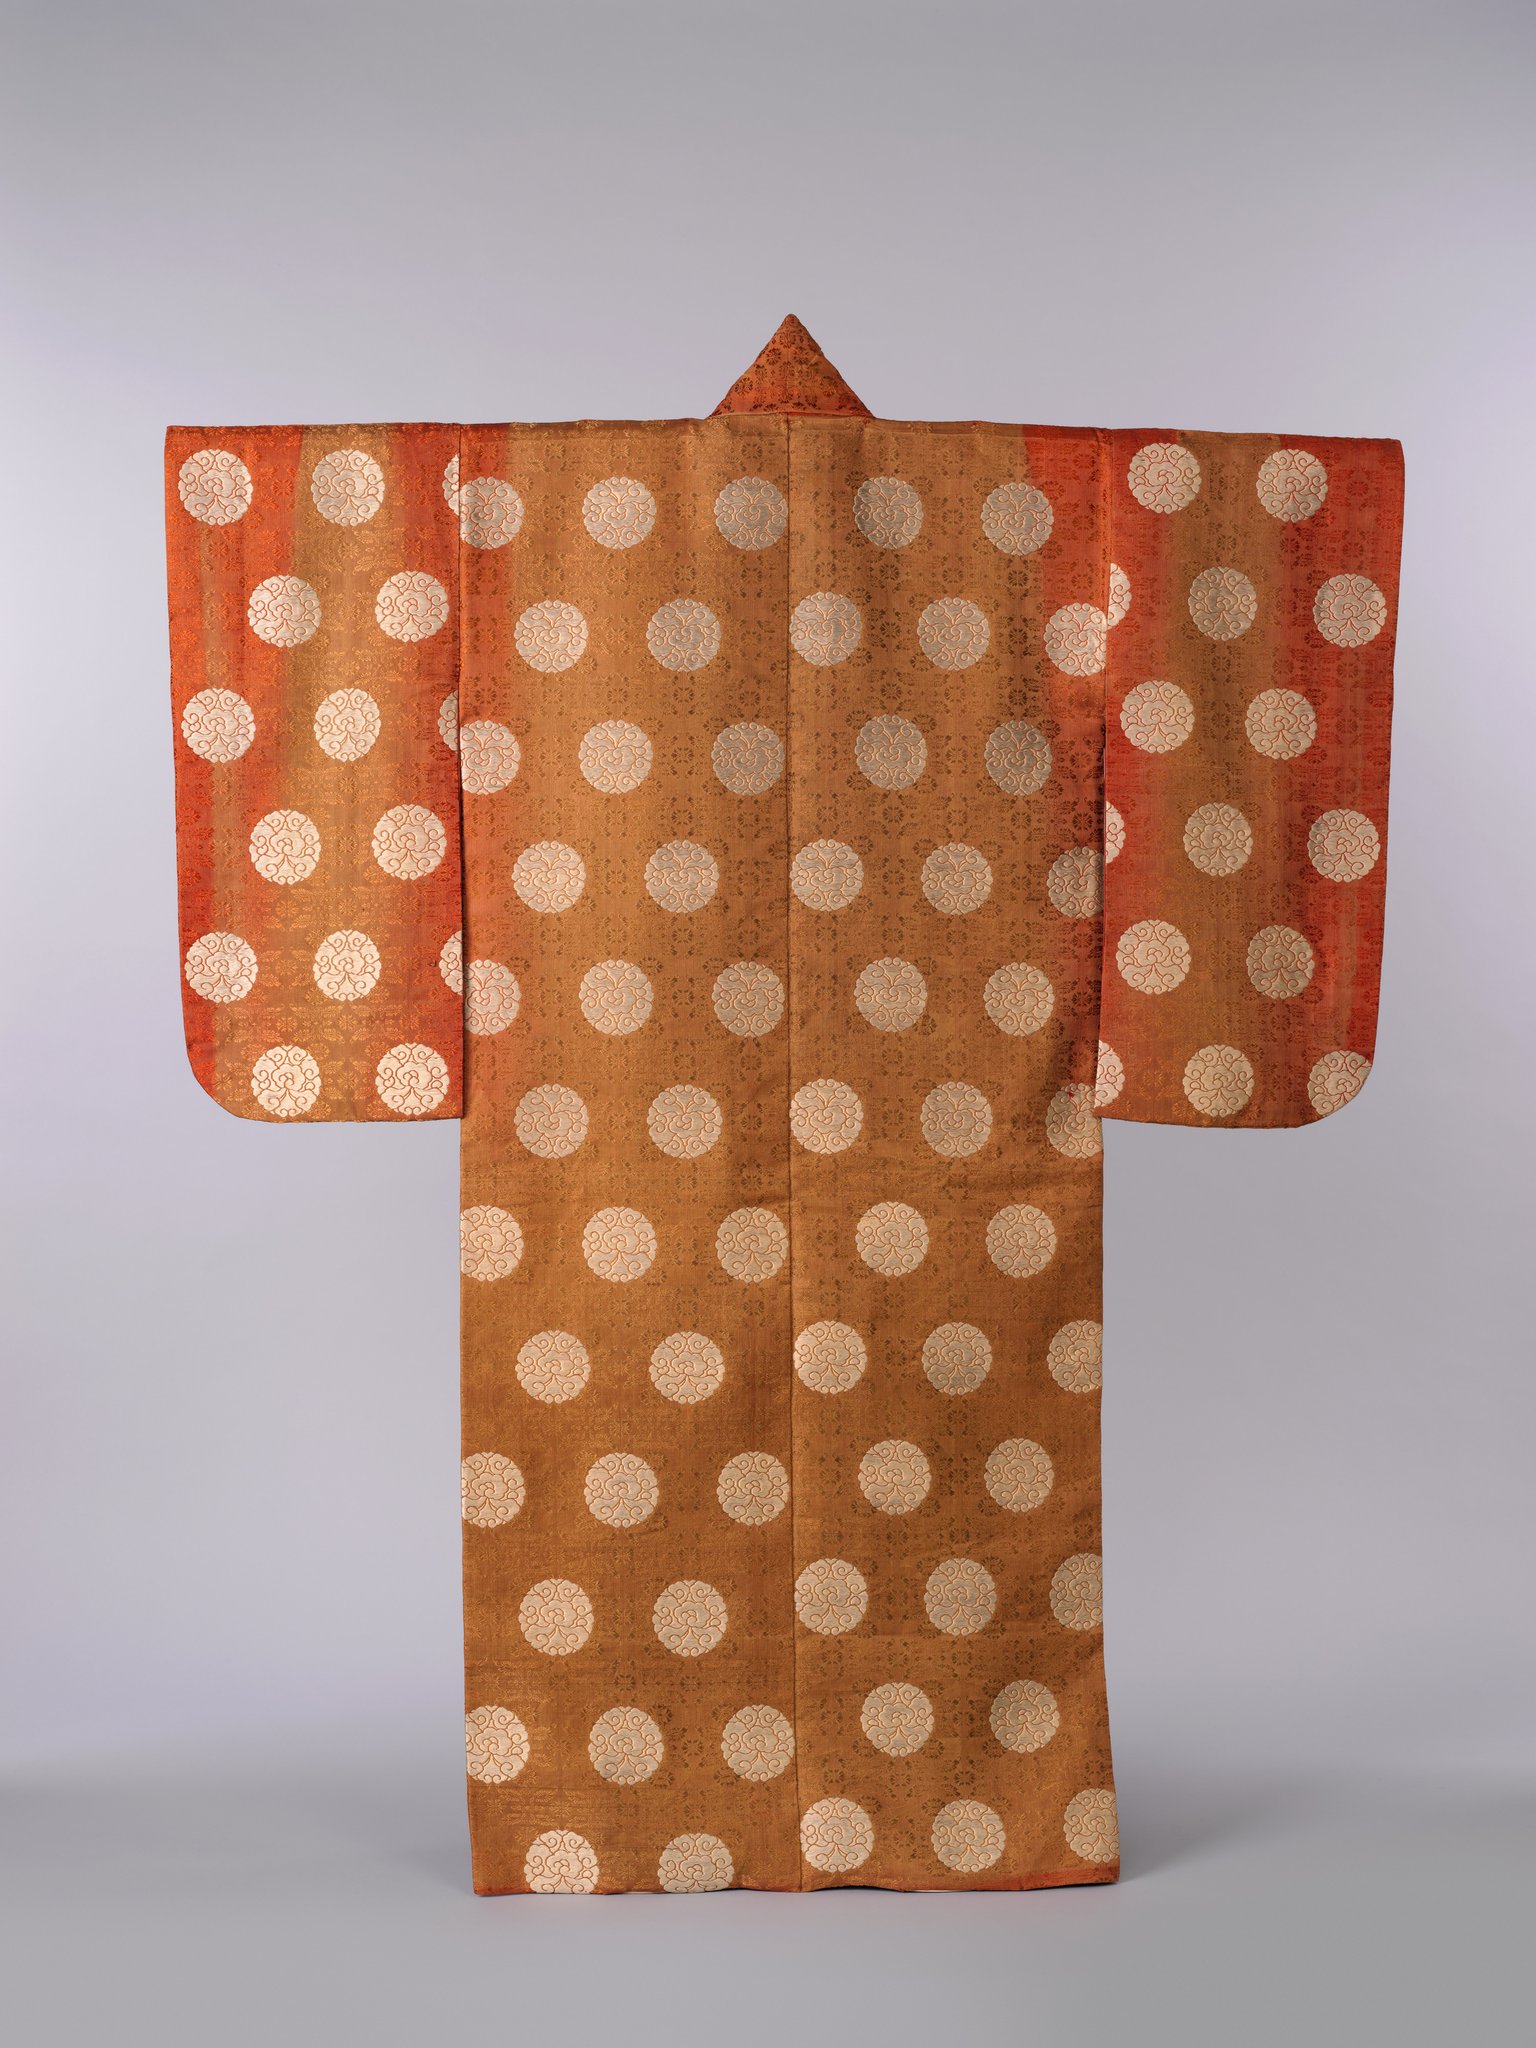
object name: noh robe karaori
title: Noh Robe (Karaori)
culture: japanese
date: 1751-1800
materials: silk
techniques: brocade, patterning, weave